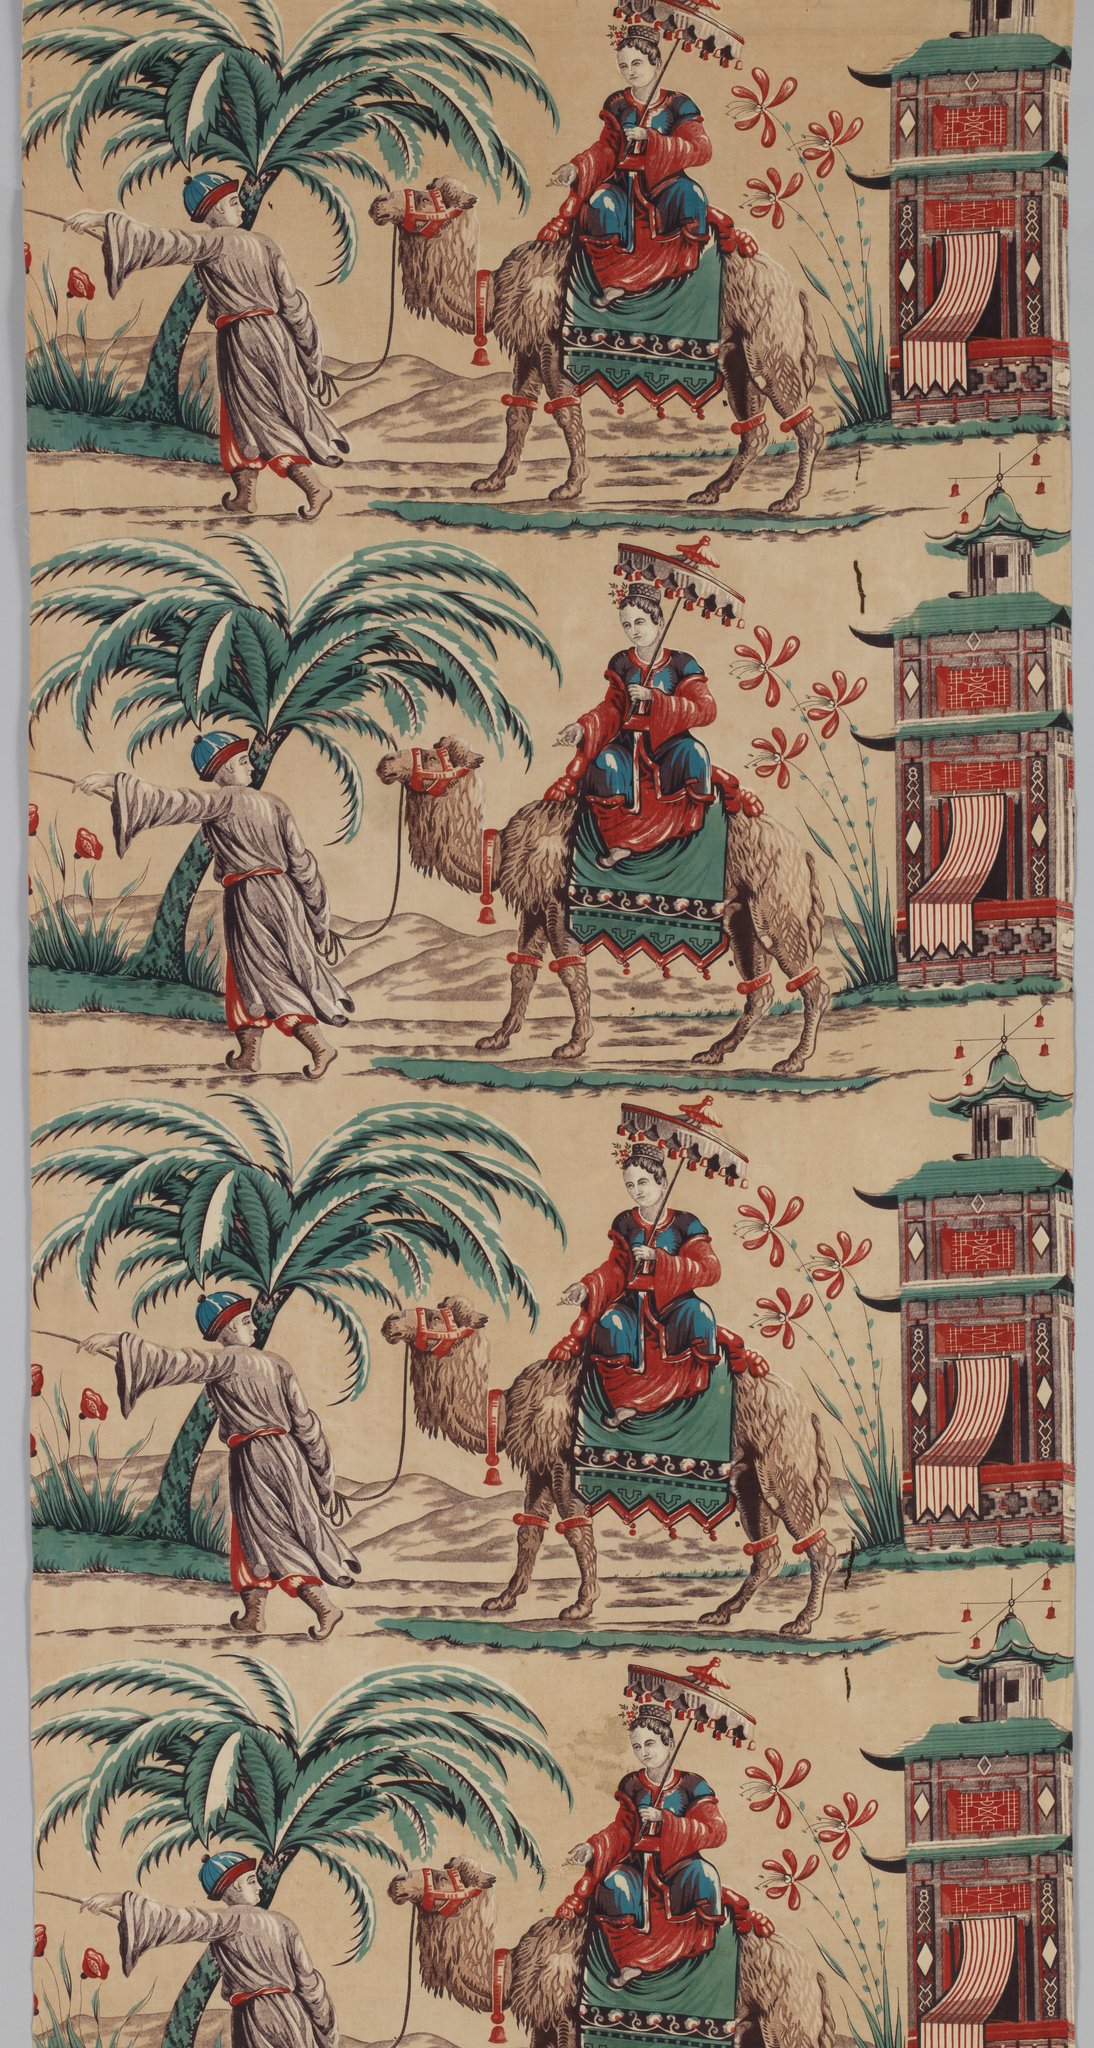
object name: piece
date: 1820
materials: cotton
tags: men,women,camels